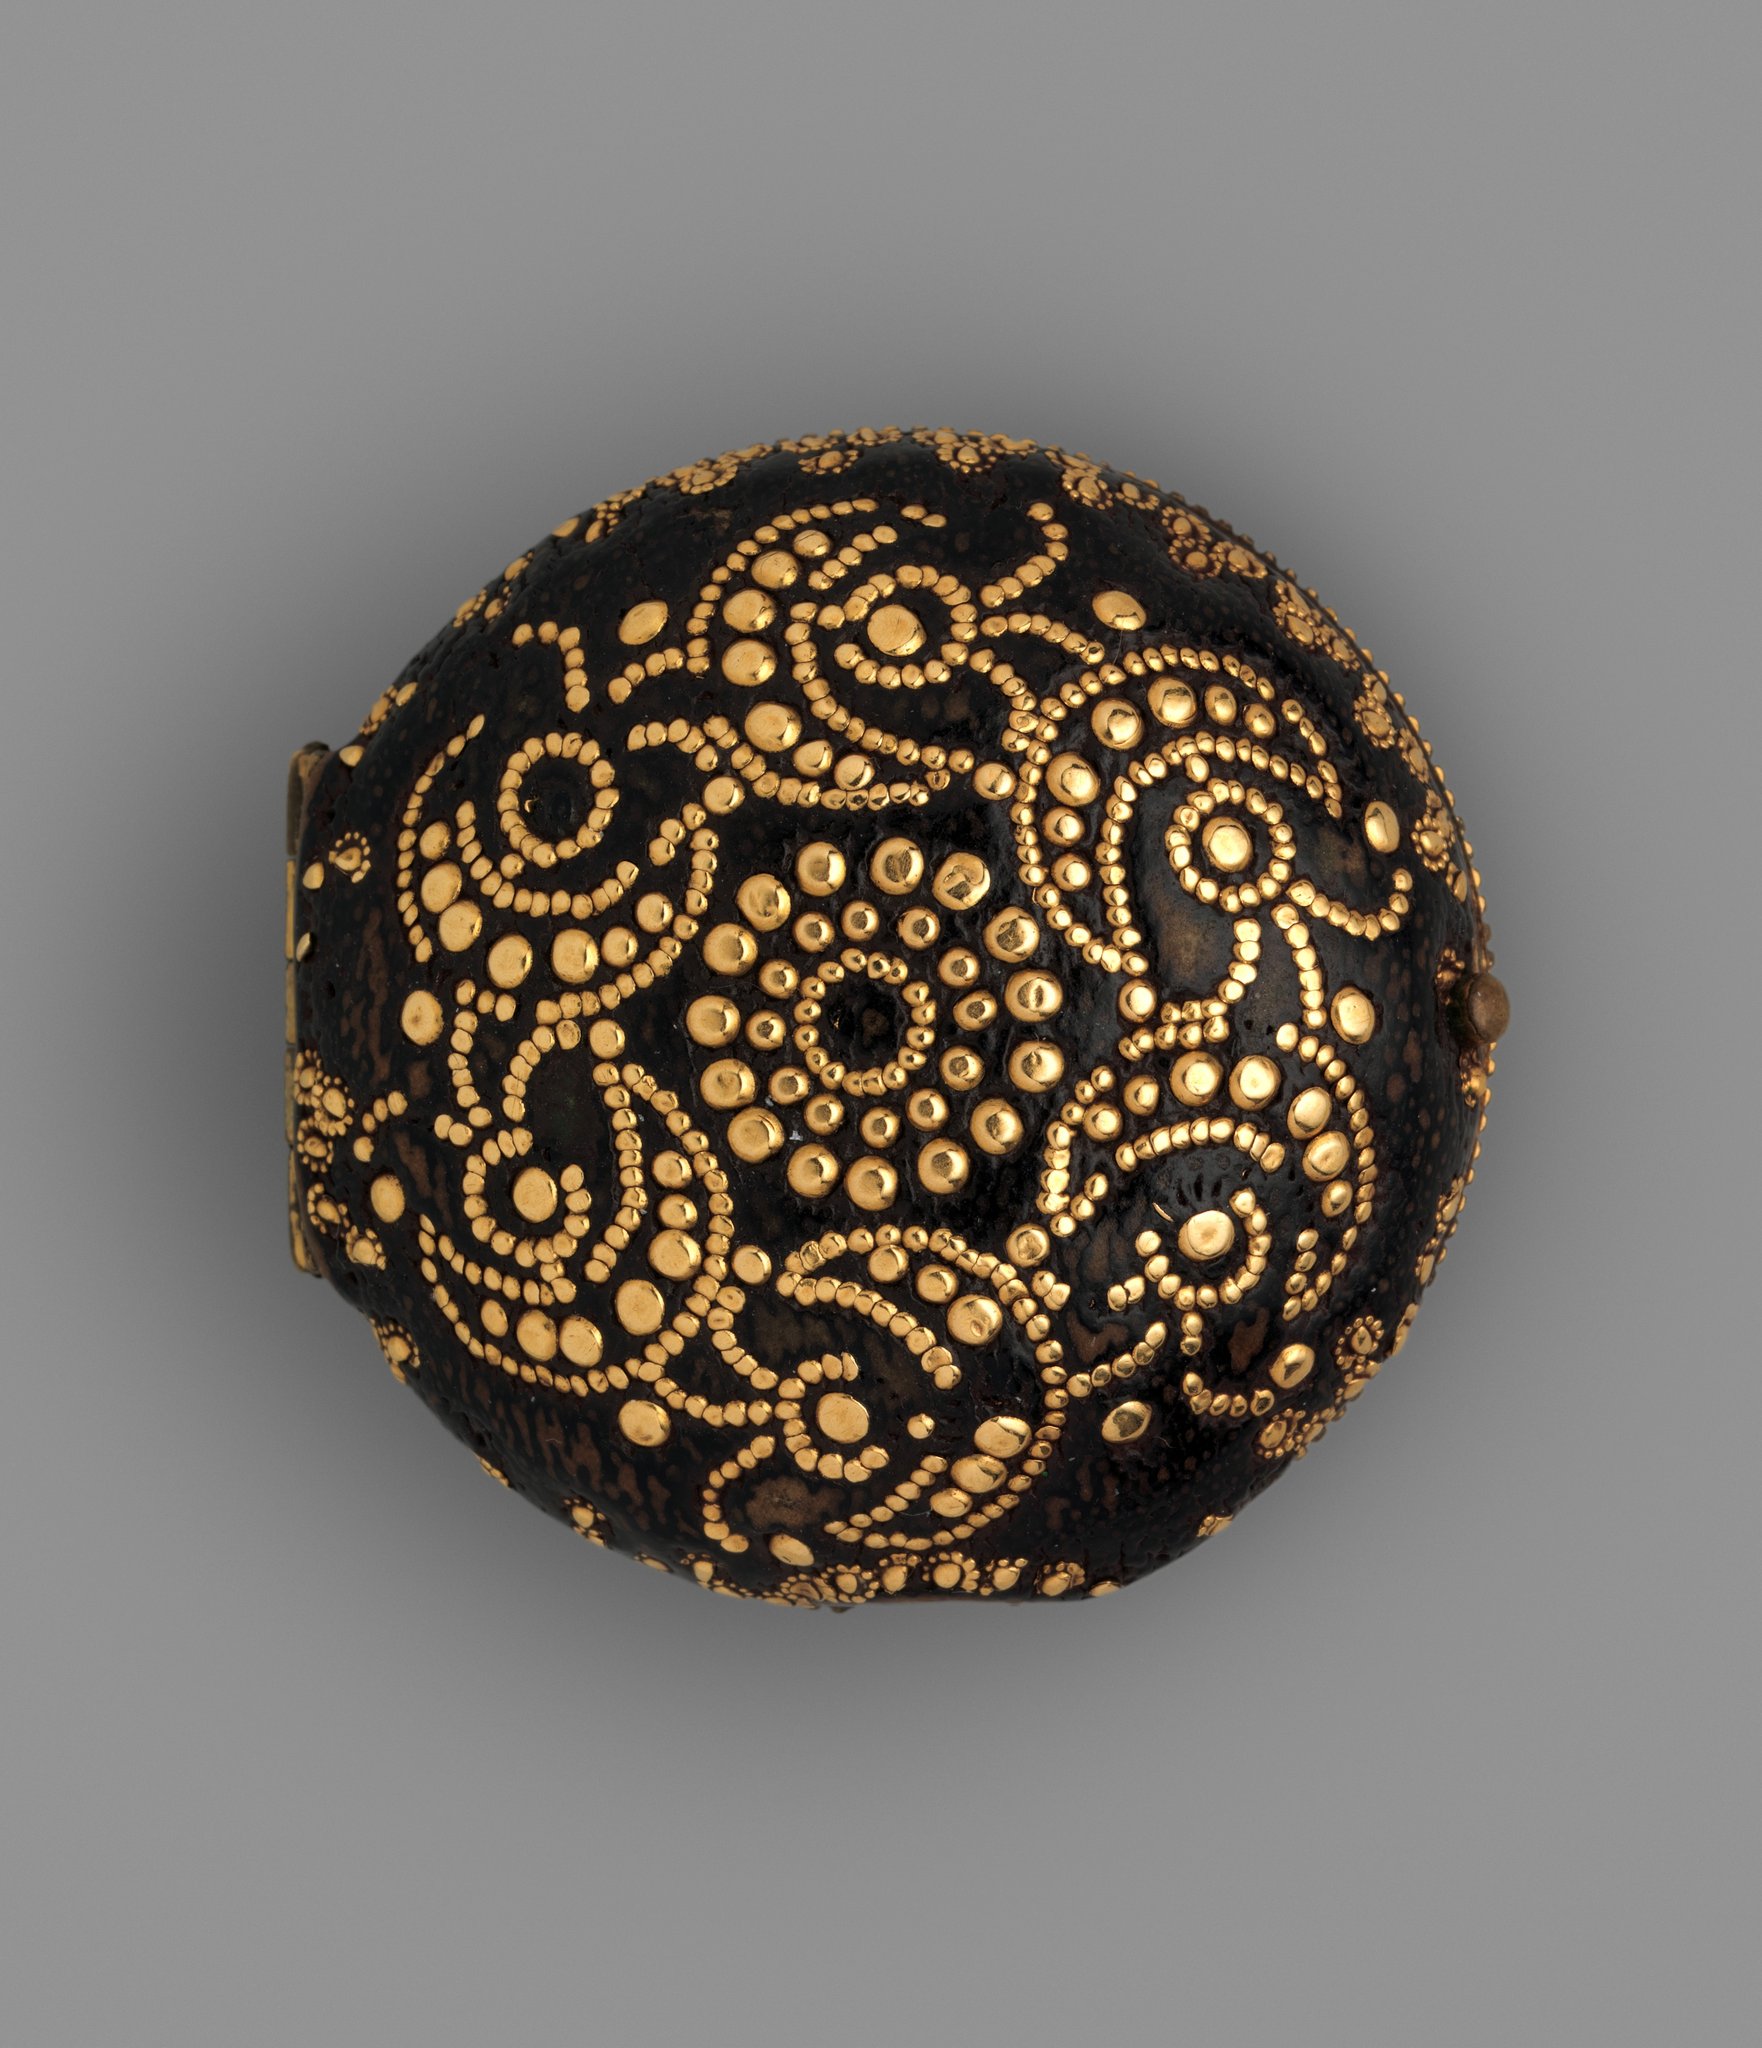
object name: watch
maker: nicolas massy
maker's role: maker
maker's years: 1598-1698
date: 1660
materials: gold, leather